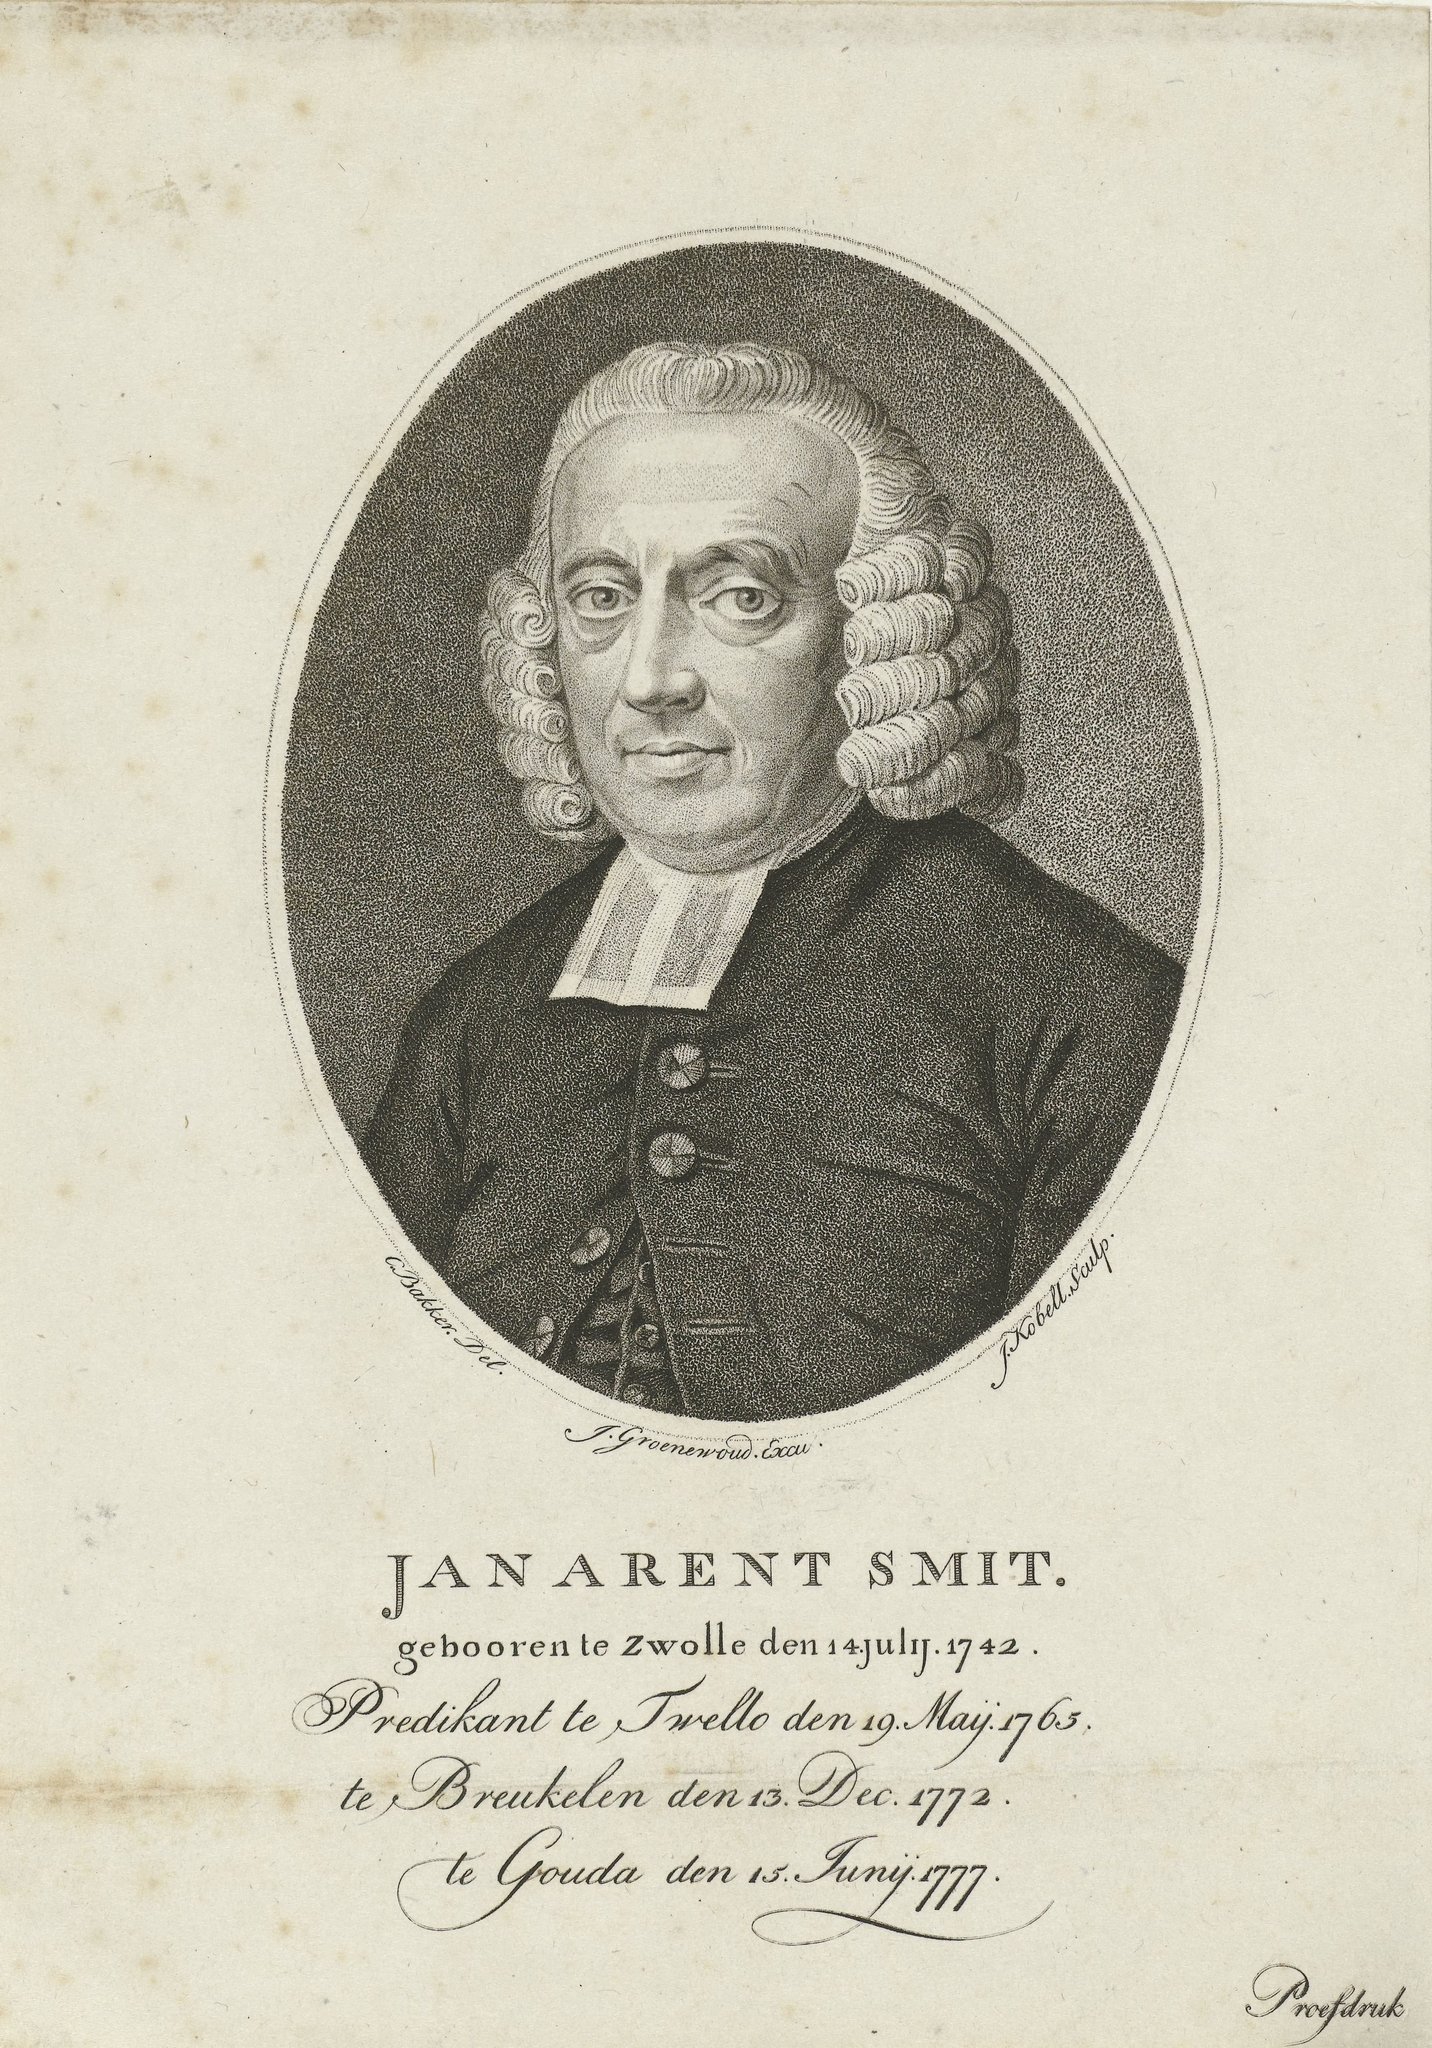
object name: print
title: Jan Arent Smit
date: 1777-1833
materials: paper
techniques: etching, engraving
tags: wig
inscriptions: collector's mark: Lugt 2228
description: Portretbuste van Jan Arent Smit, predikant te Twello, Breukelen en Gouda. Smit draagt een batterijpruik en een bef. Onder de afbeelding een vierregelig onderschrift in het Nederlands.